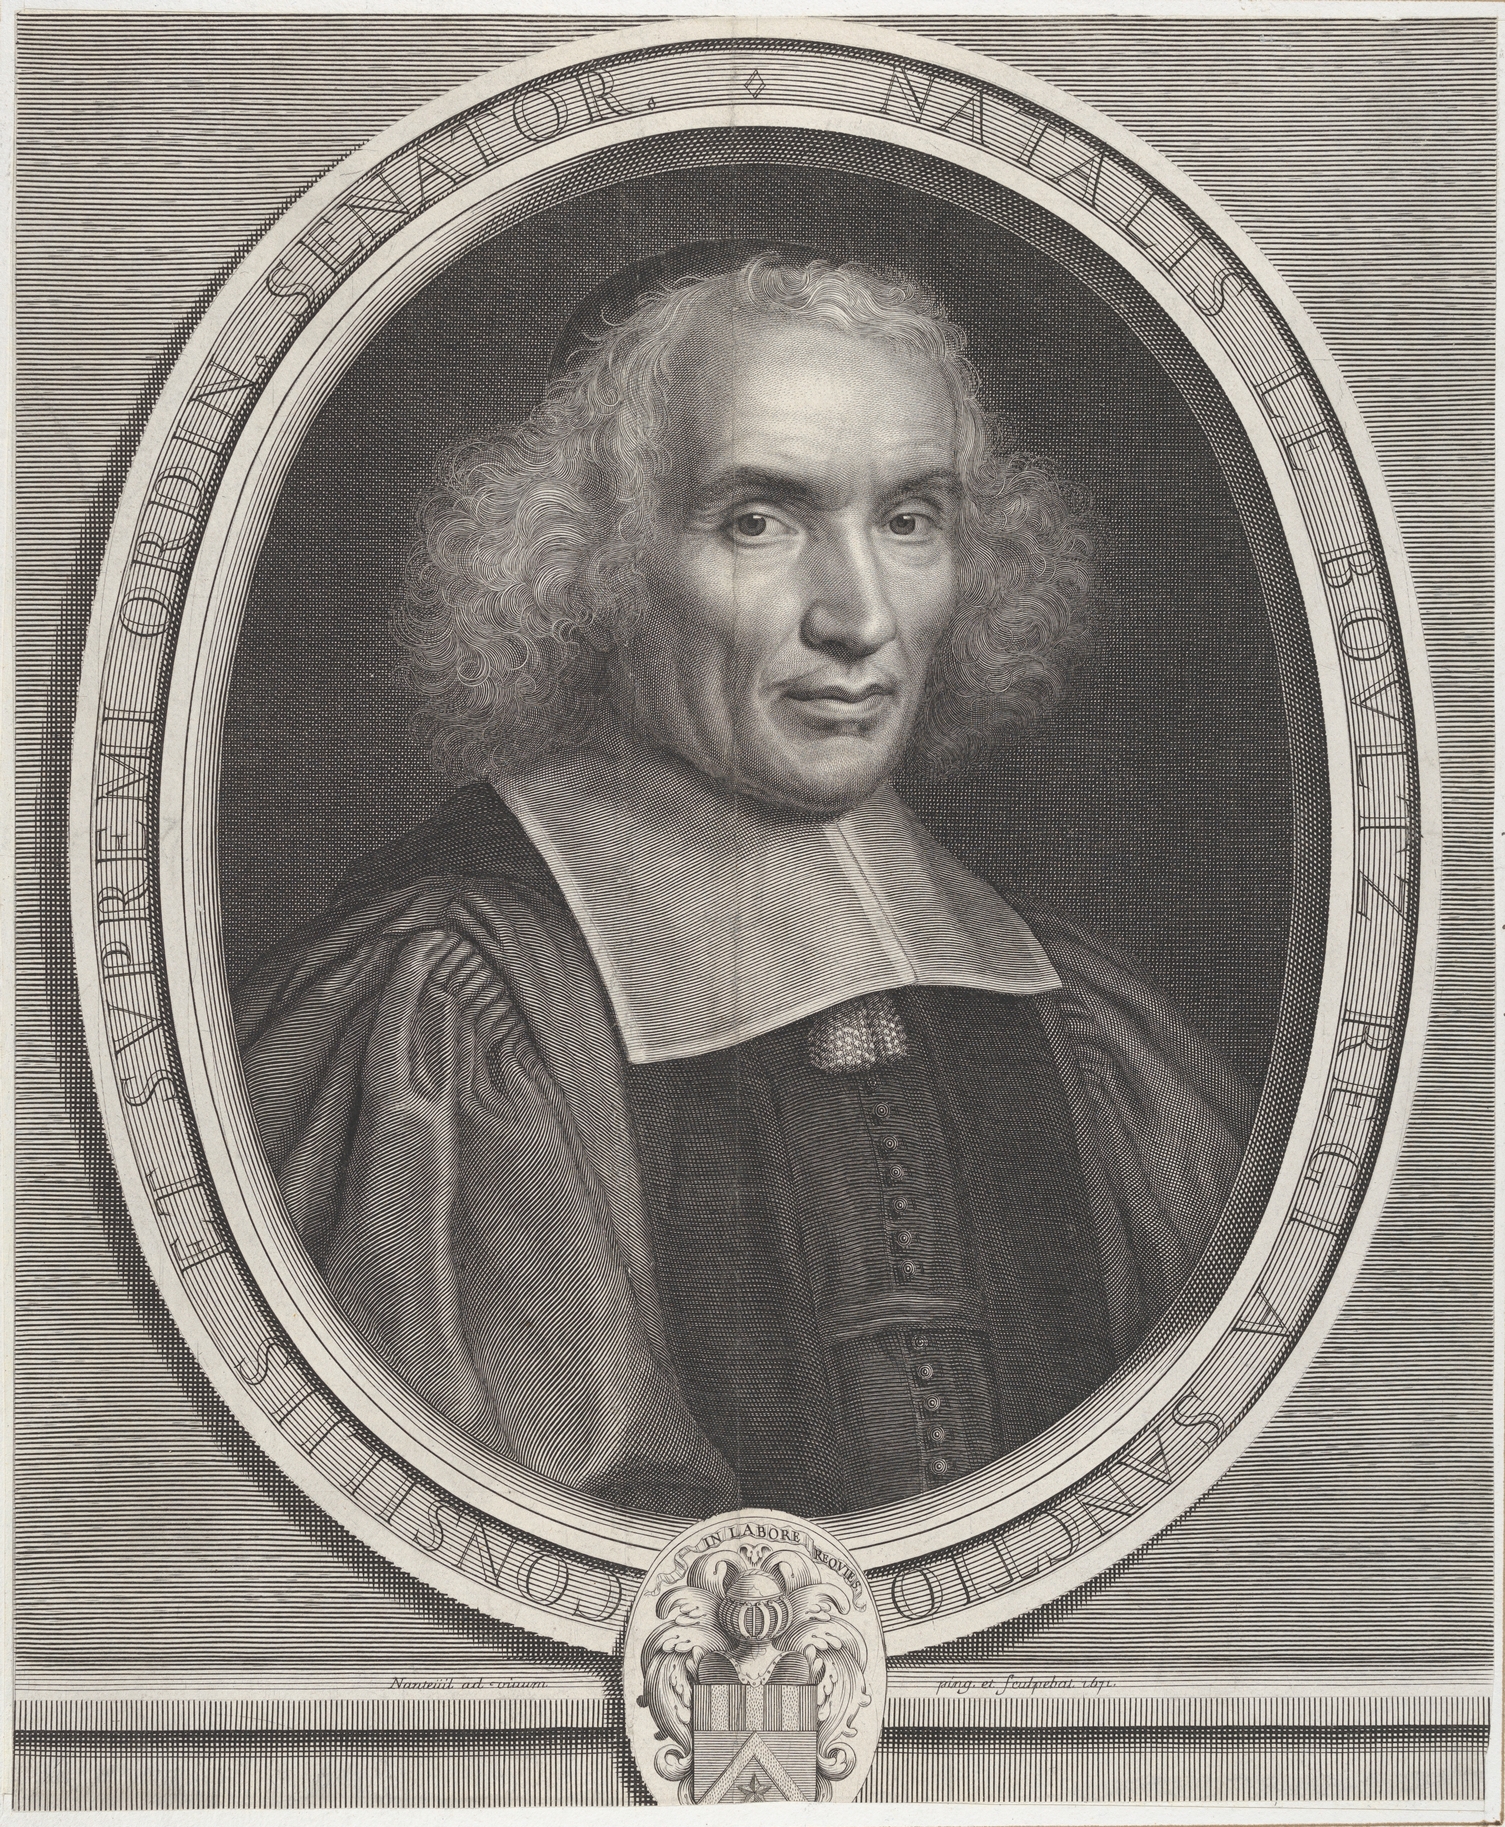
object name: print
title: Noël Le Boultz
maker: robert nanteuil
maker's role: artist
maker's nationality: french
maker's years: 1623-1678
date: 1671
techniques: engraving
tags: men,portraits,coat of arms